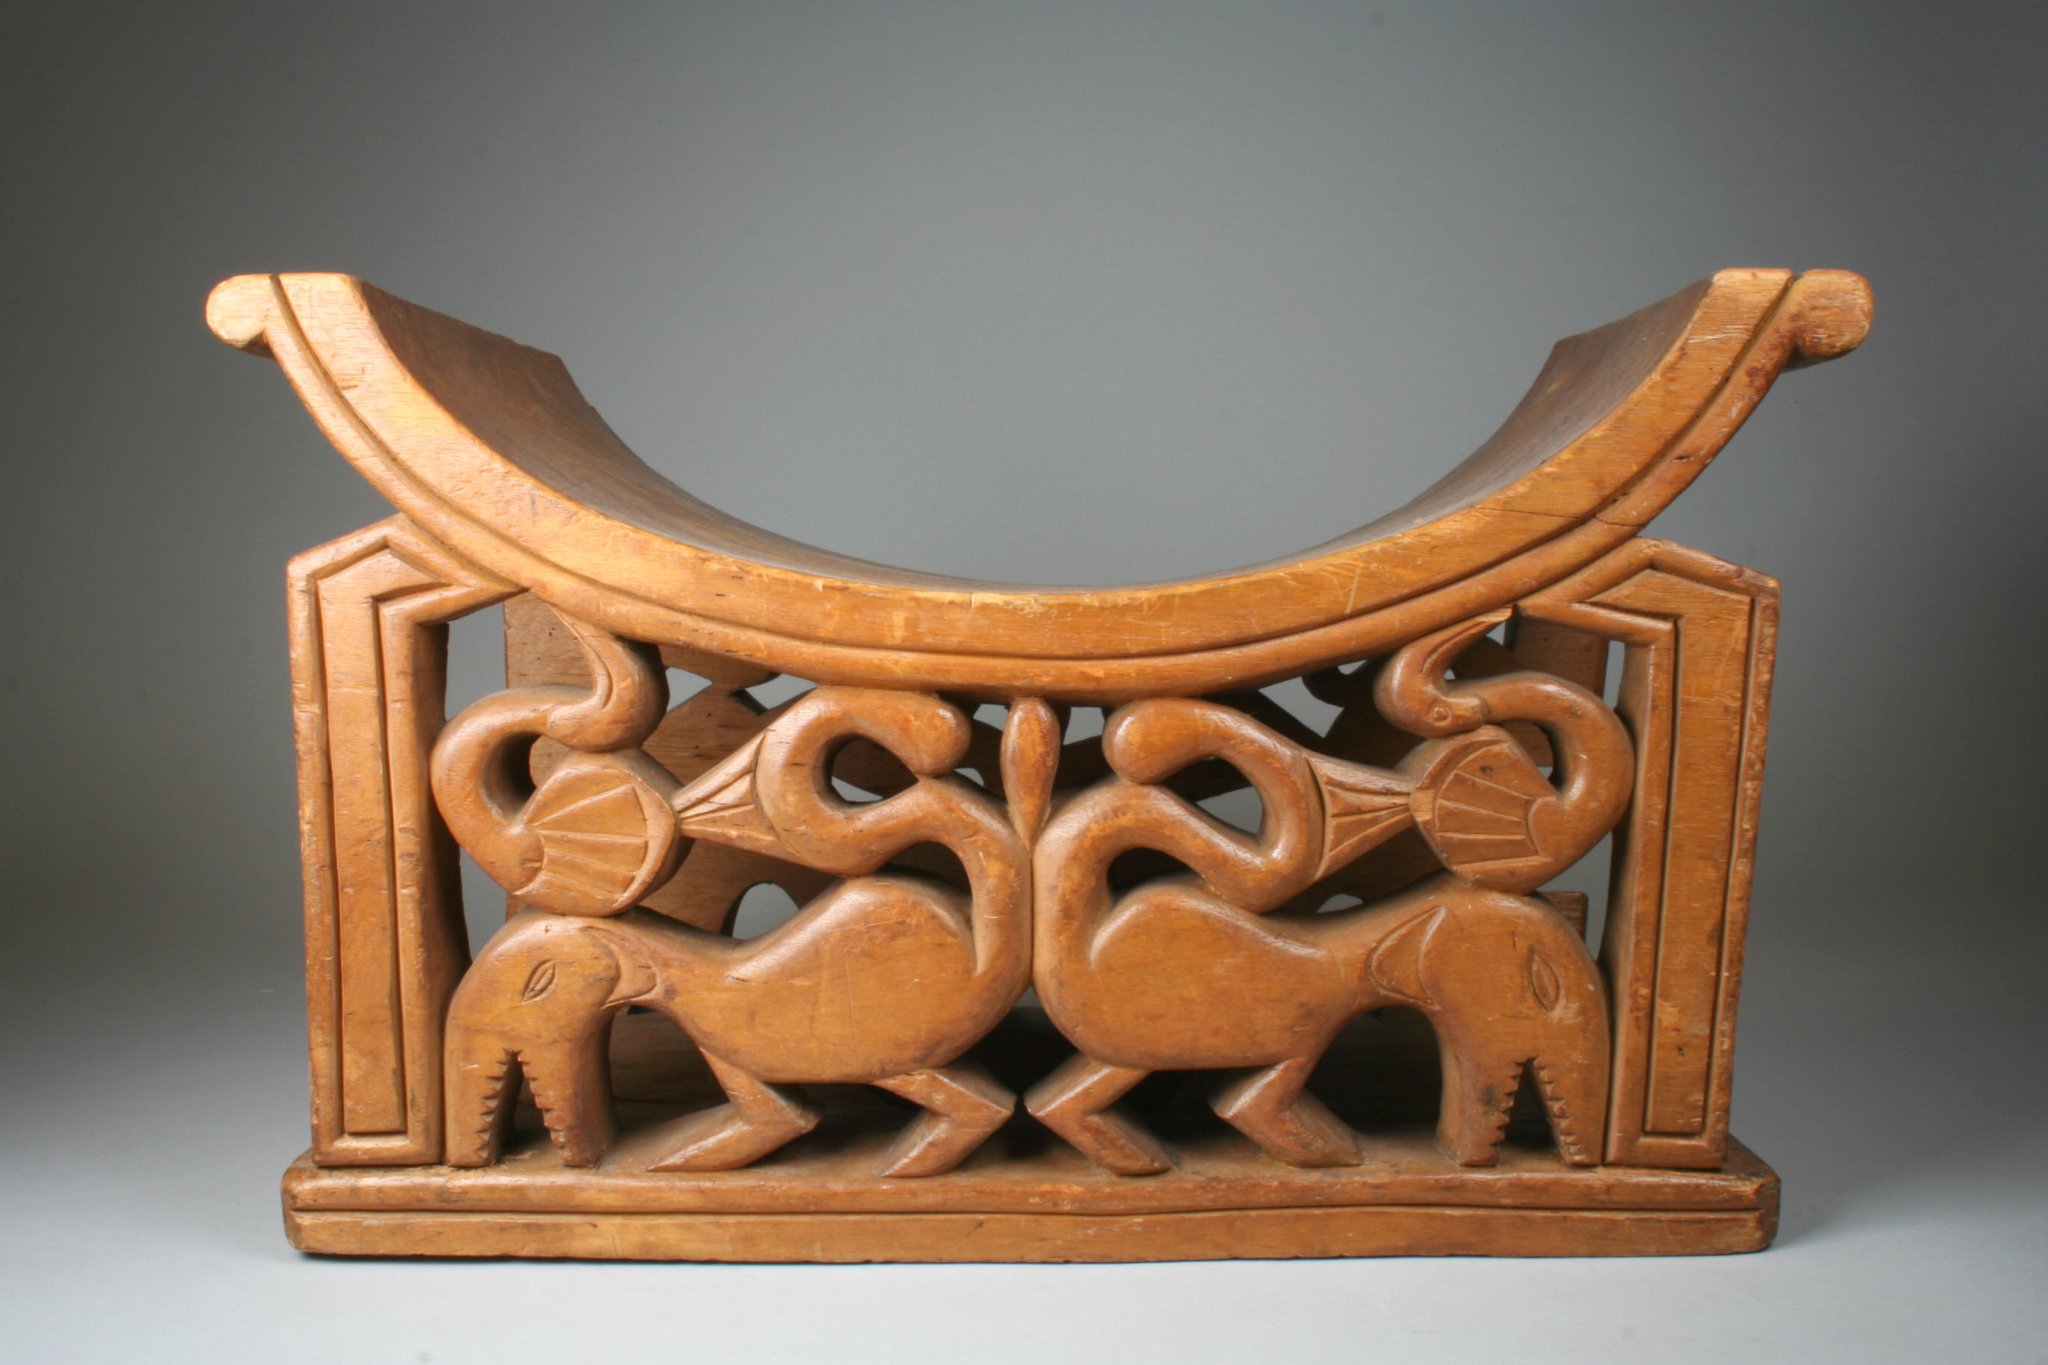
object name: stool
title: Prestige seat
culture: duala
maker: duala artist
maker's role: artist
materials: wood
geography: cameroon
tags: animals